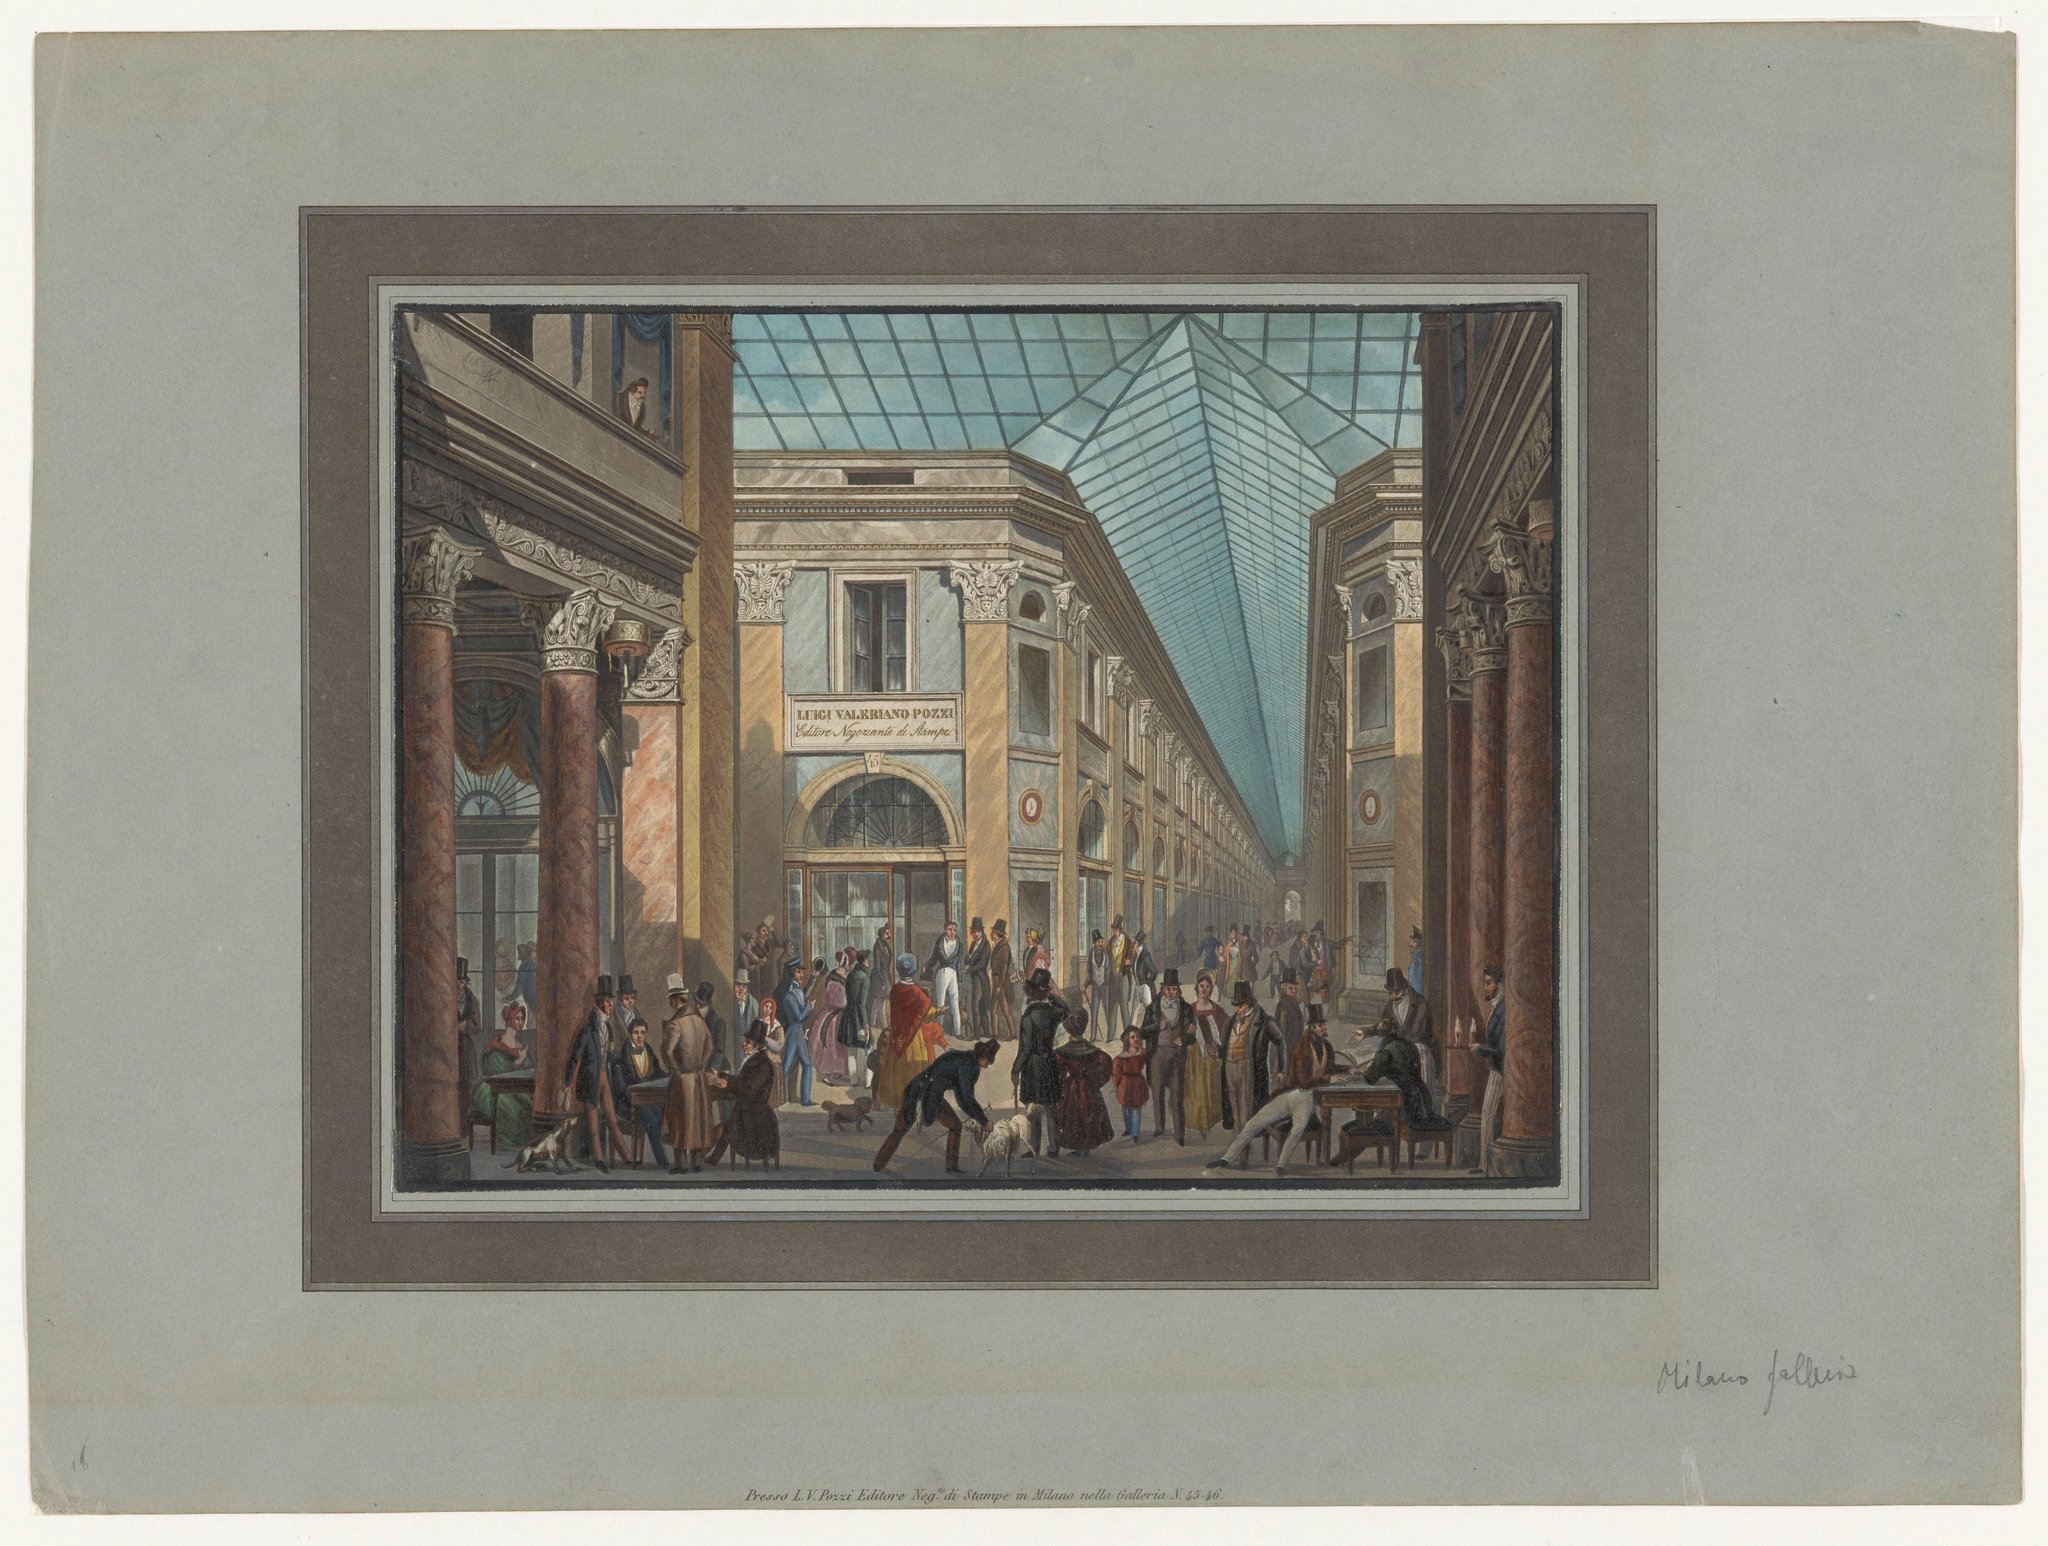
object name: print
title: De prenthandel van Luigi Valeriano Pozzi in de Galleria Vittorio Emanuele te Milaan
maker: luigi valeriano pozzi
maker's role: print maker, publisher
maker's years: 1778-1847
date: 1788-1847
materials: paper, watercolor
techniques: brush, etching, hand coloring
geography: milan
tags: art trade, art shop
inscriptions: collector's mark: Lugt 2228, collector's mark: Lugt 2760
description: Gezicht in de overdekte winkelgalerij, de Galleria Vittorio Emanuele, met op de gevel van een van de winkels de naam van Luigi Valeriano Pozzi. Tussen de winkels veel publiek.